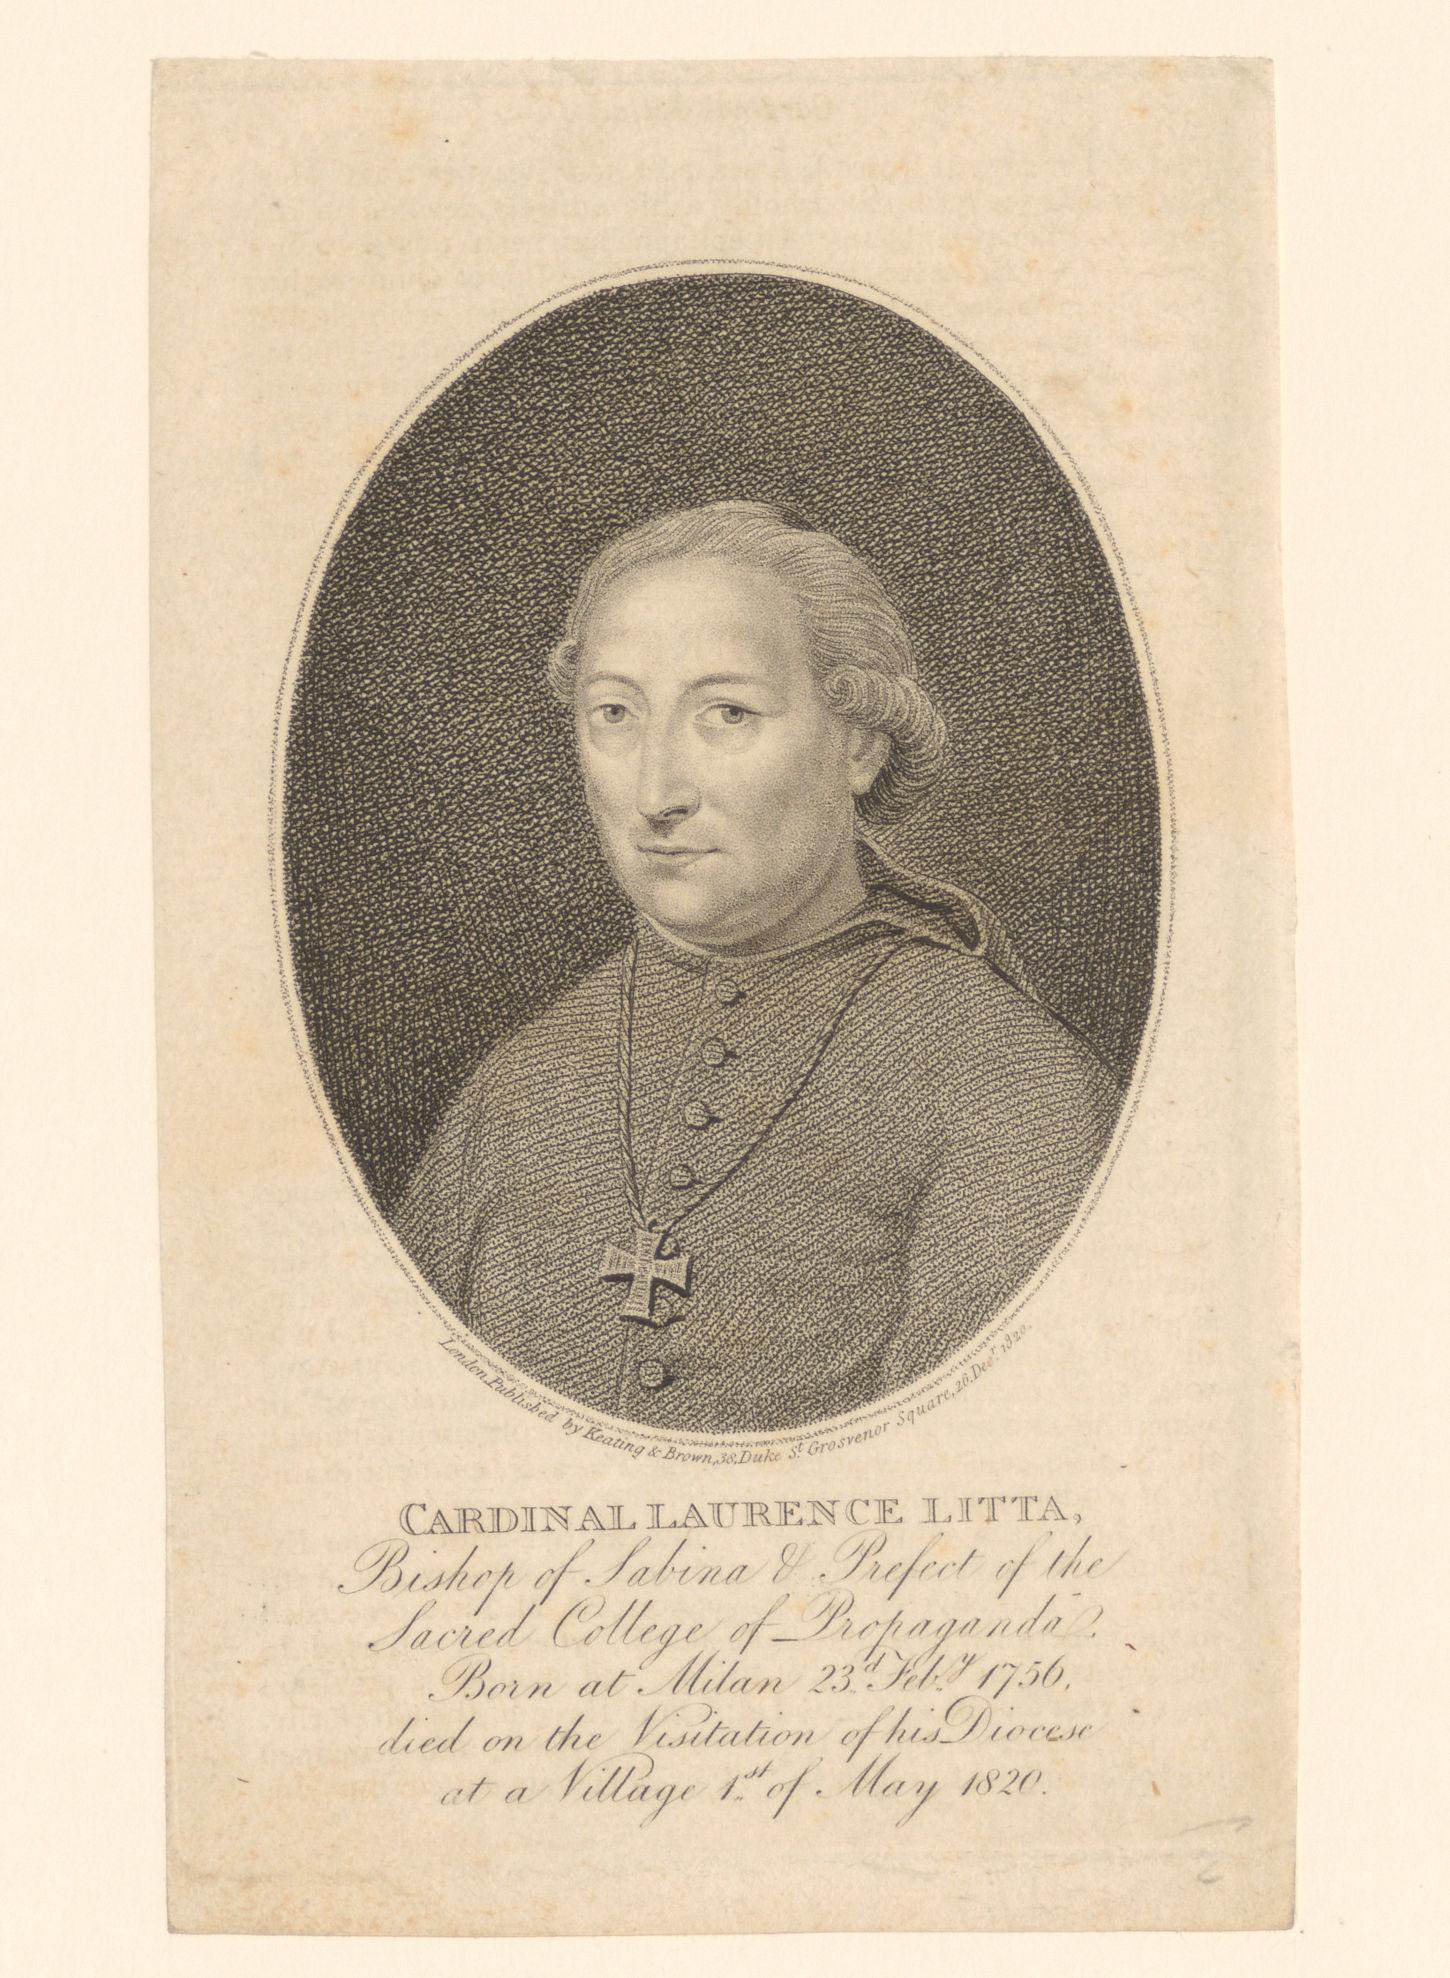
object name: print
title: Portret van Lorenzo Litta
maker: george keating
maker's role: print maker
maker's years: 1762-1842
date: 1820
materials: paper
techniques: etching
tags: cardinal, historical persons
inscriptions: collector's mark: Lugt 2228